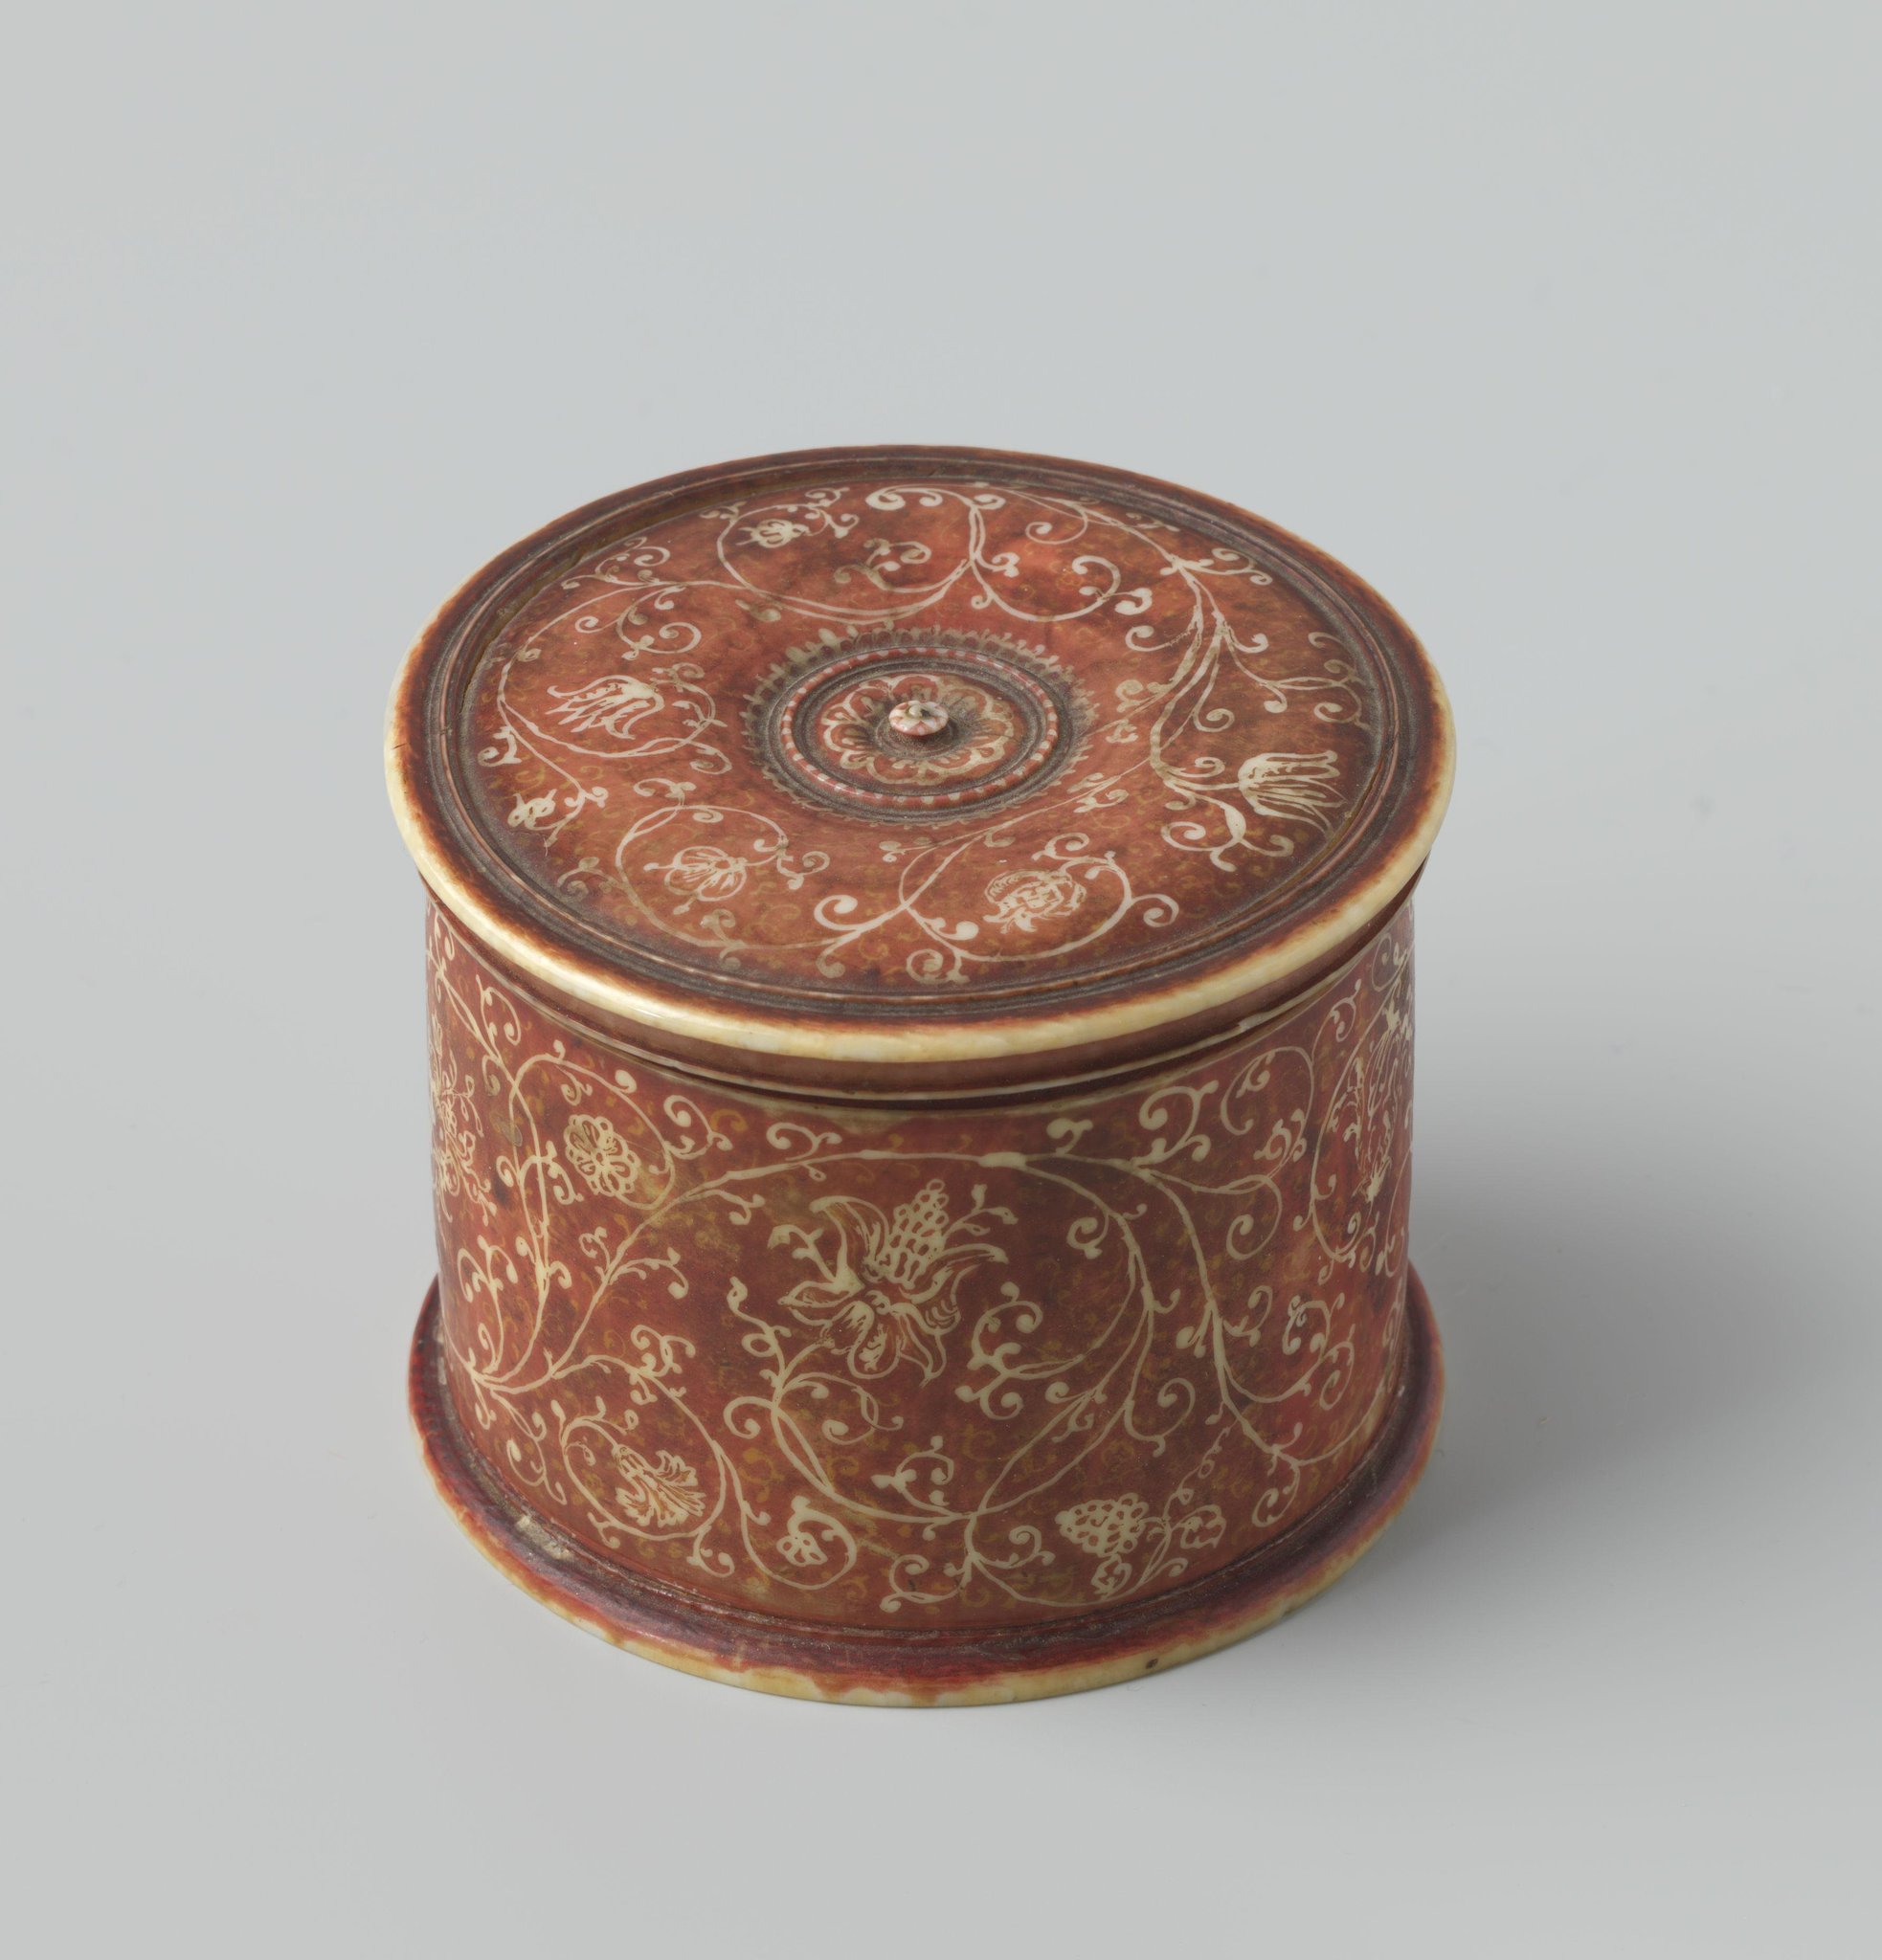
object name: box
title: Ivoren huwelijksdoosje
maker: Anonymous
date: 1642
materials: ivory, paint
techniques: cutting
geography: netherlands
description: Rond doosje van ivoor met los deksel, met in rode verf versieringen in de vorm van ranken, met aan de binnenzijde van de deksel rond een hart met twee pijlen de tekst 'De liefde overwint het al', waaronder twee in elkaar grijpende handen, waaronder 'Anno 1642'.